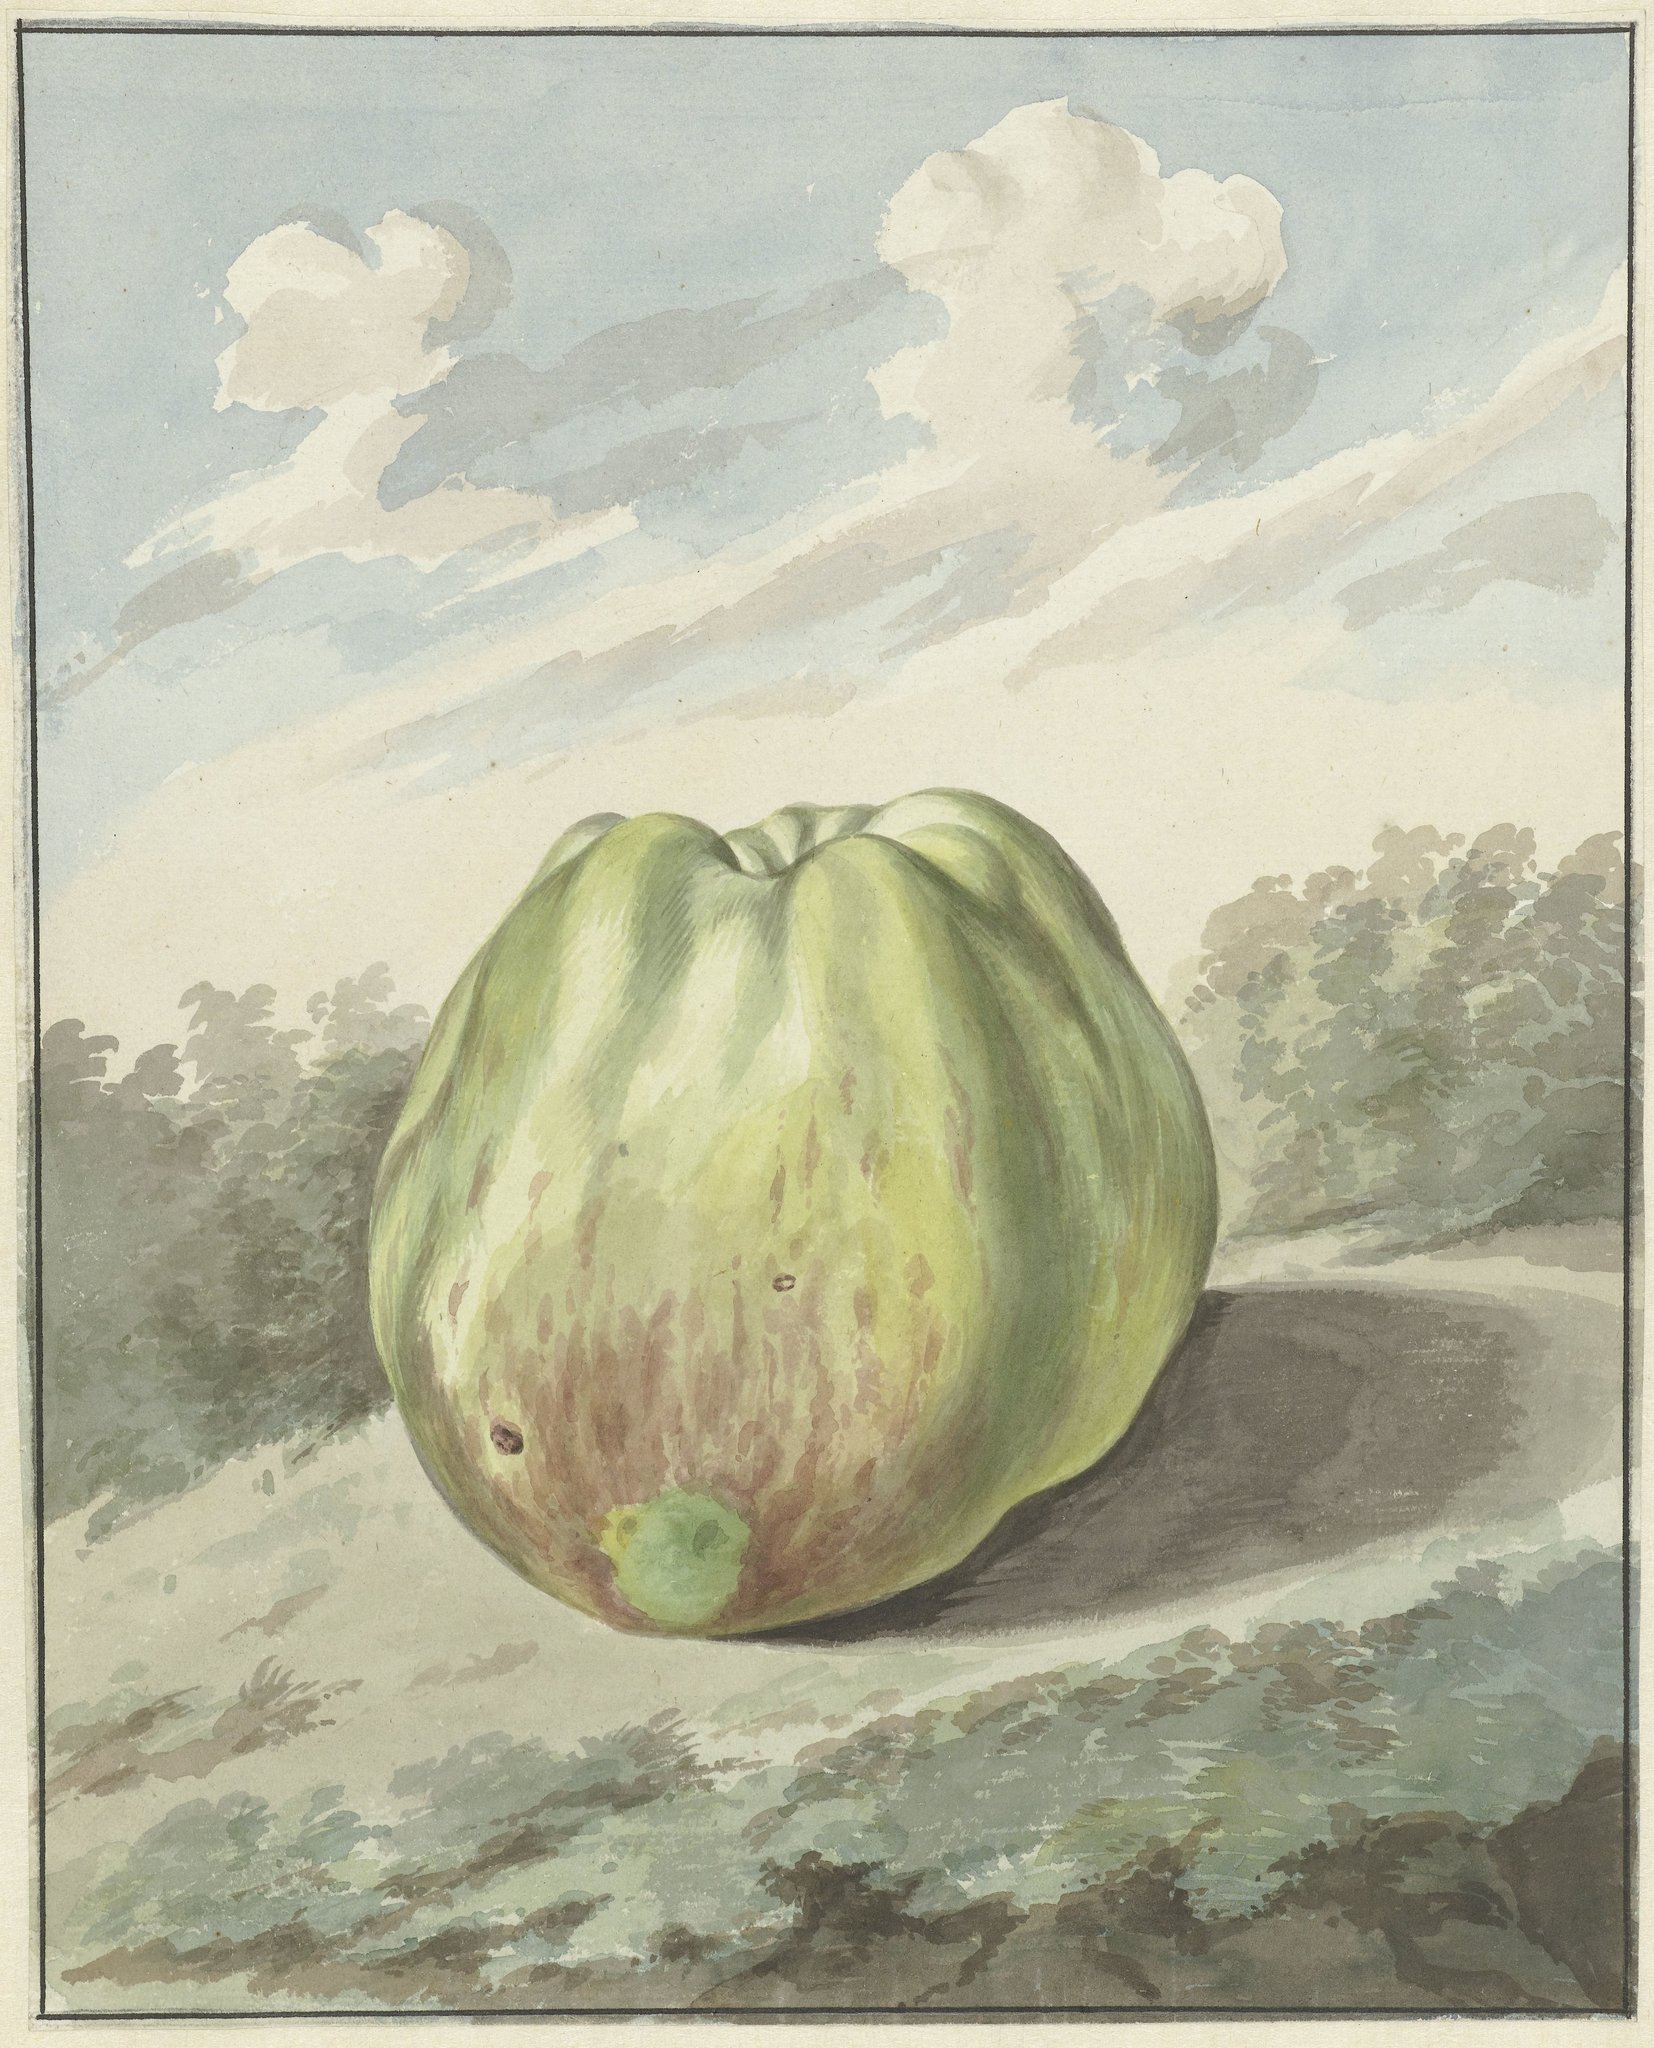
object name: watercolor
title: Appel in een landschap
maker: pieter gevers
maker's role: draughtsman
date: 1700-1800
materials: paper, watercolor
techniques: brush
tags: fruits: apple